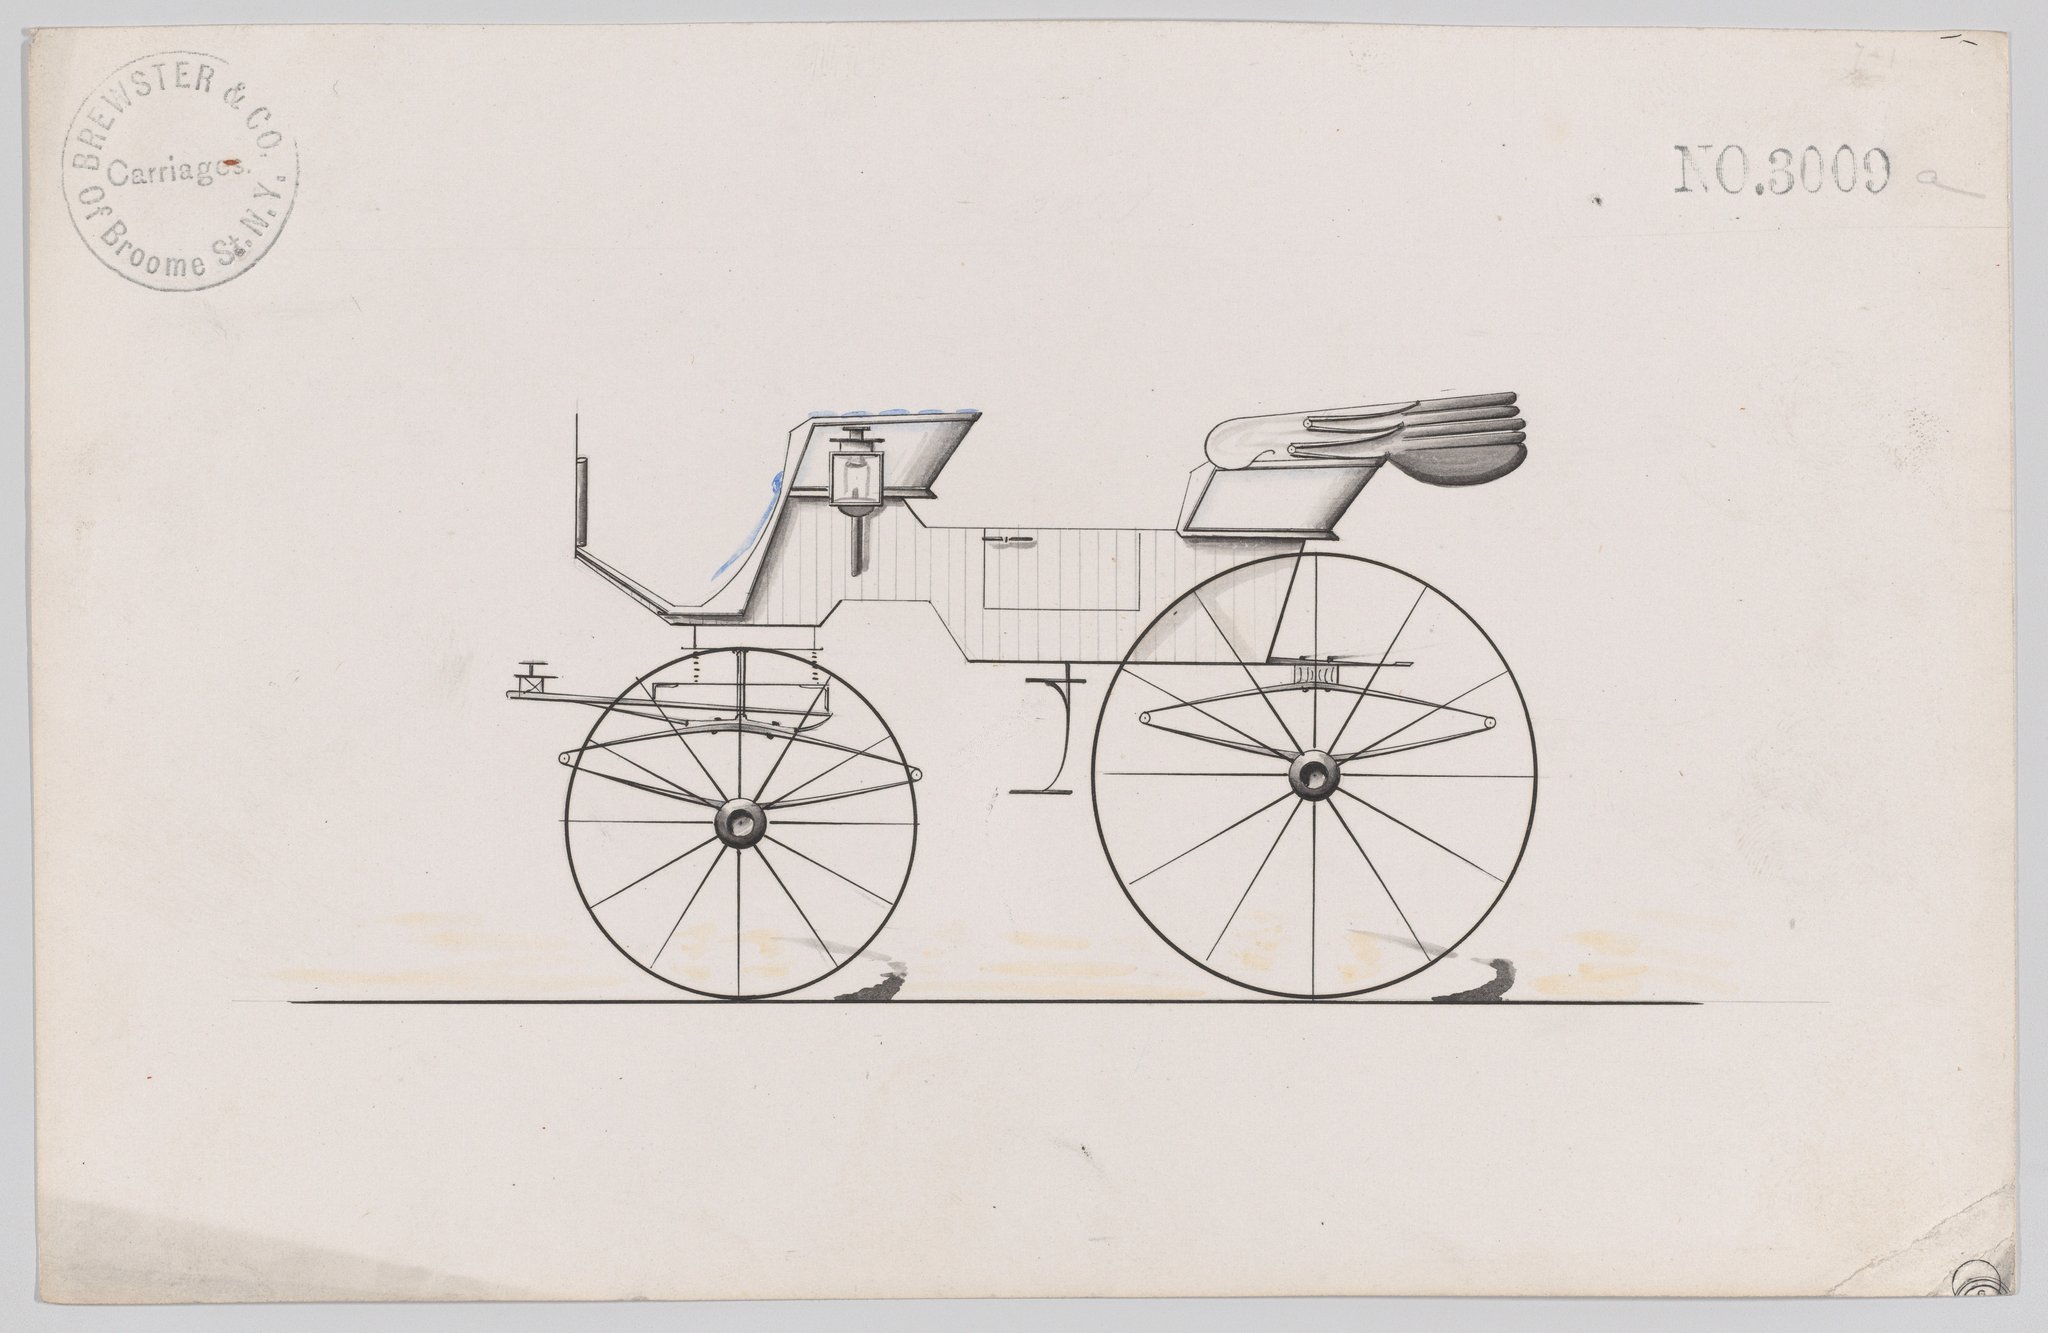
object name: drawing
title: Design for 2 seat Phaeton, no. 3009a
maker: brewster & co.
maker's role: manufacturer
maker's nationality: american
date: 1874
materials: gouache, ink, watercolor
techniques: pen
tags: carriages